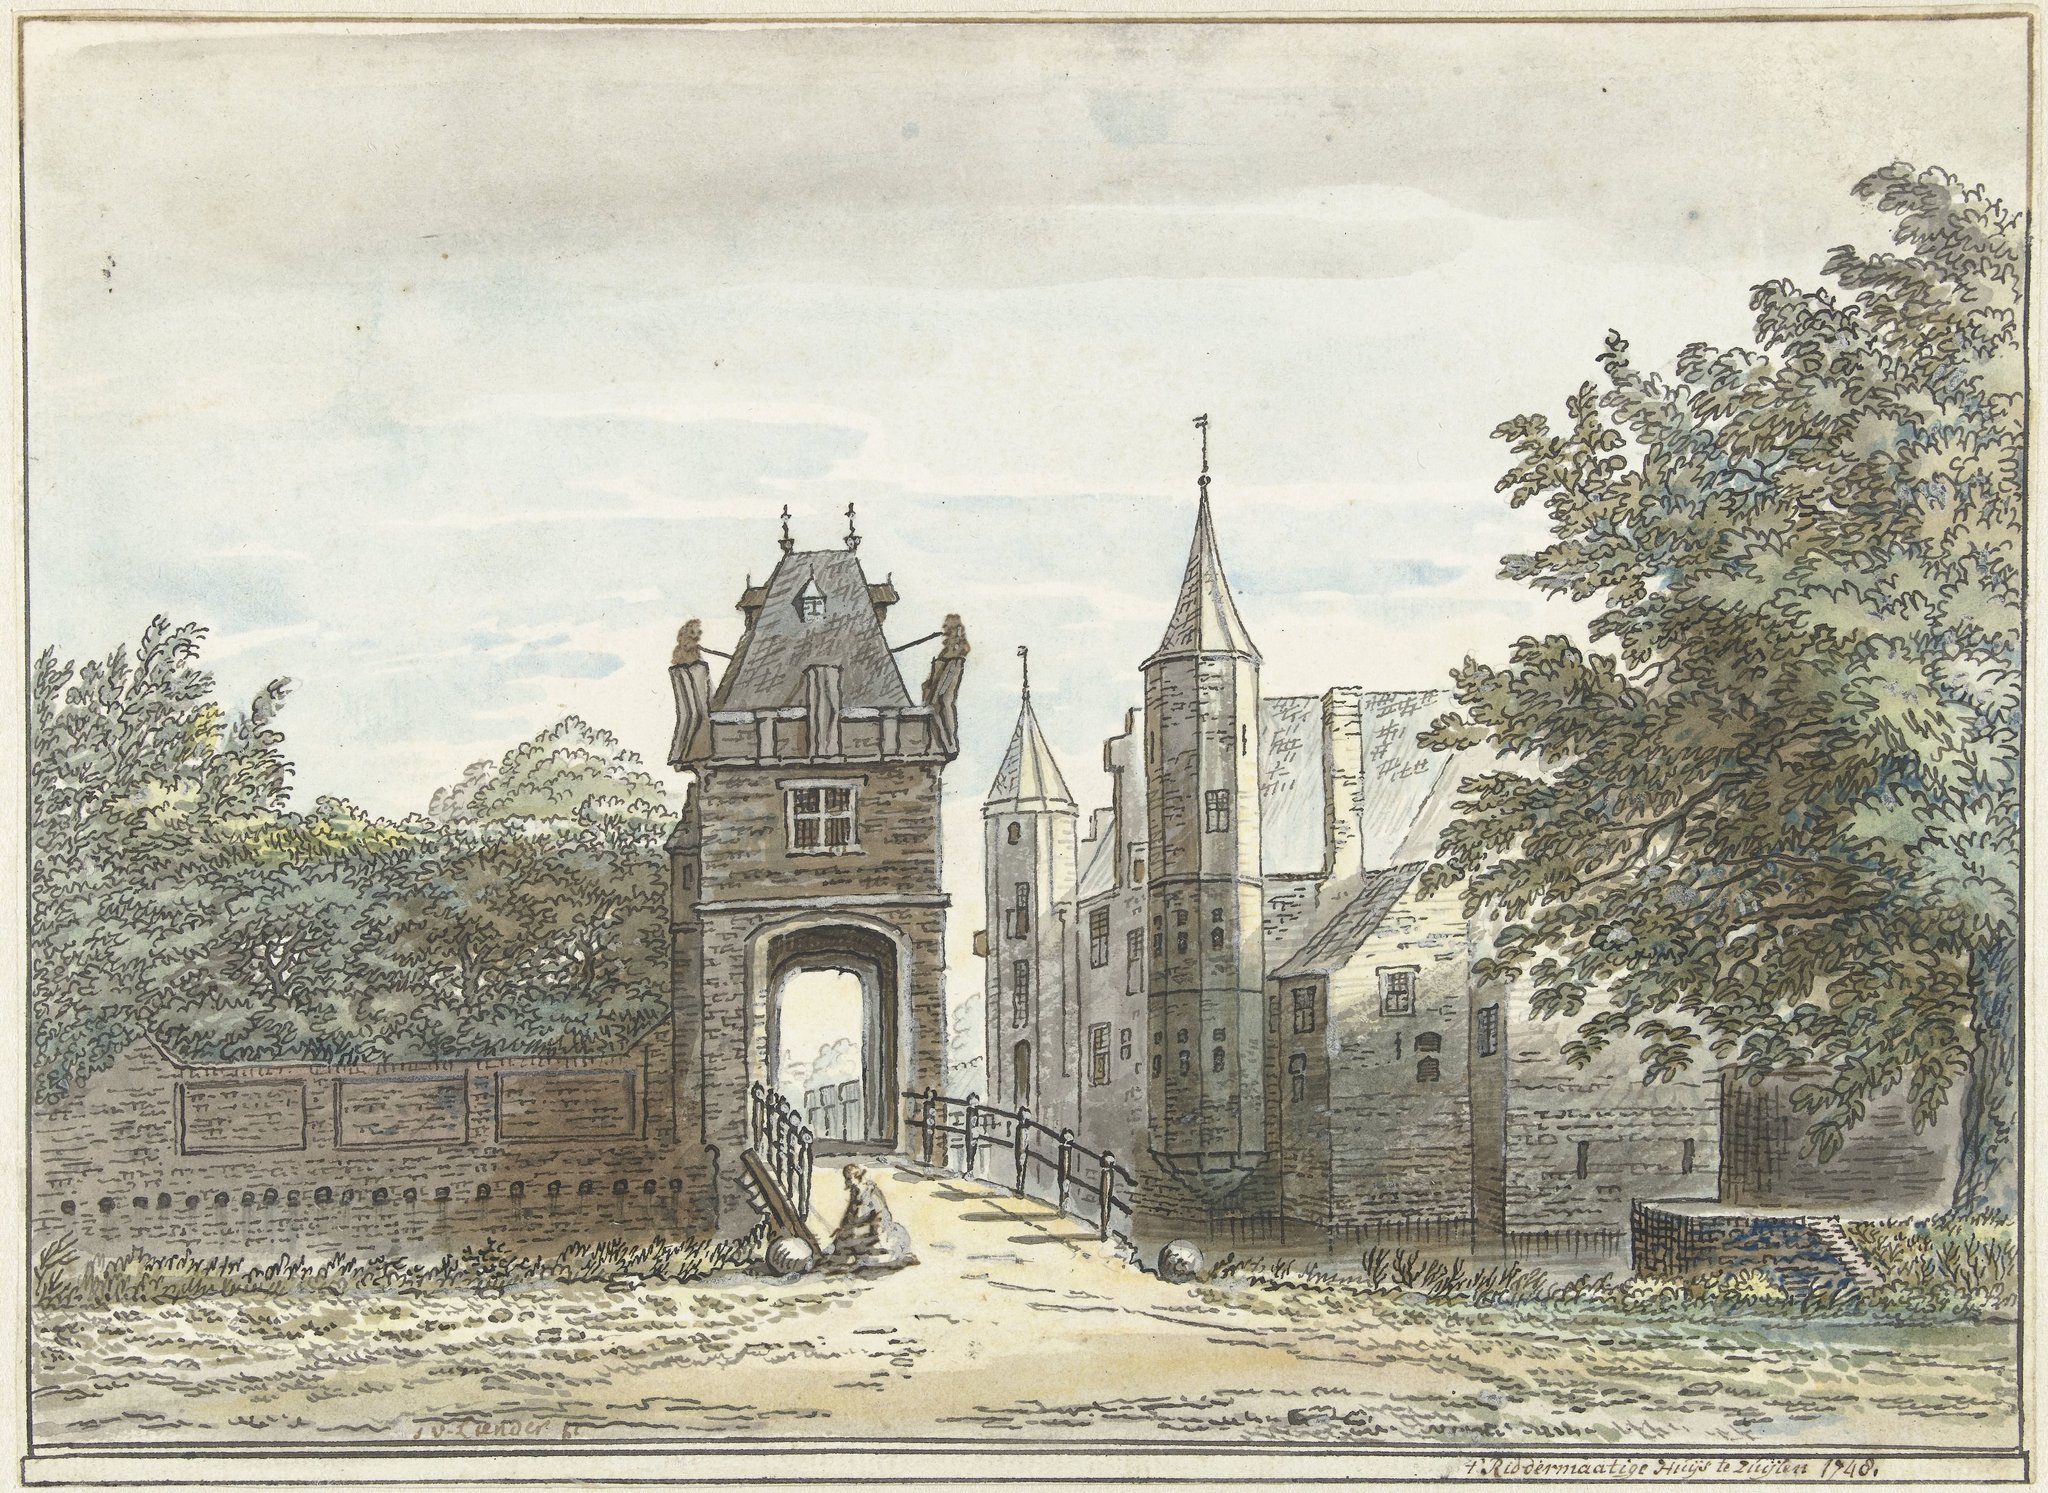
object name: drawing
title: Het Huis te Zuylen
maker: jacob van liender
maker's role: draughtsman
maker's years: 1696-1759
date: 1748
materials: paint, ink, paper, watercolor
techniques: brush, pen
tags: castle